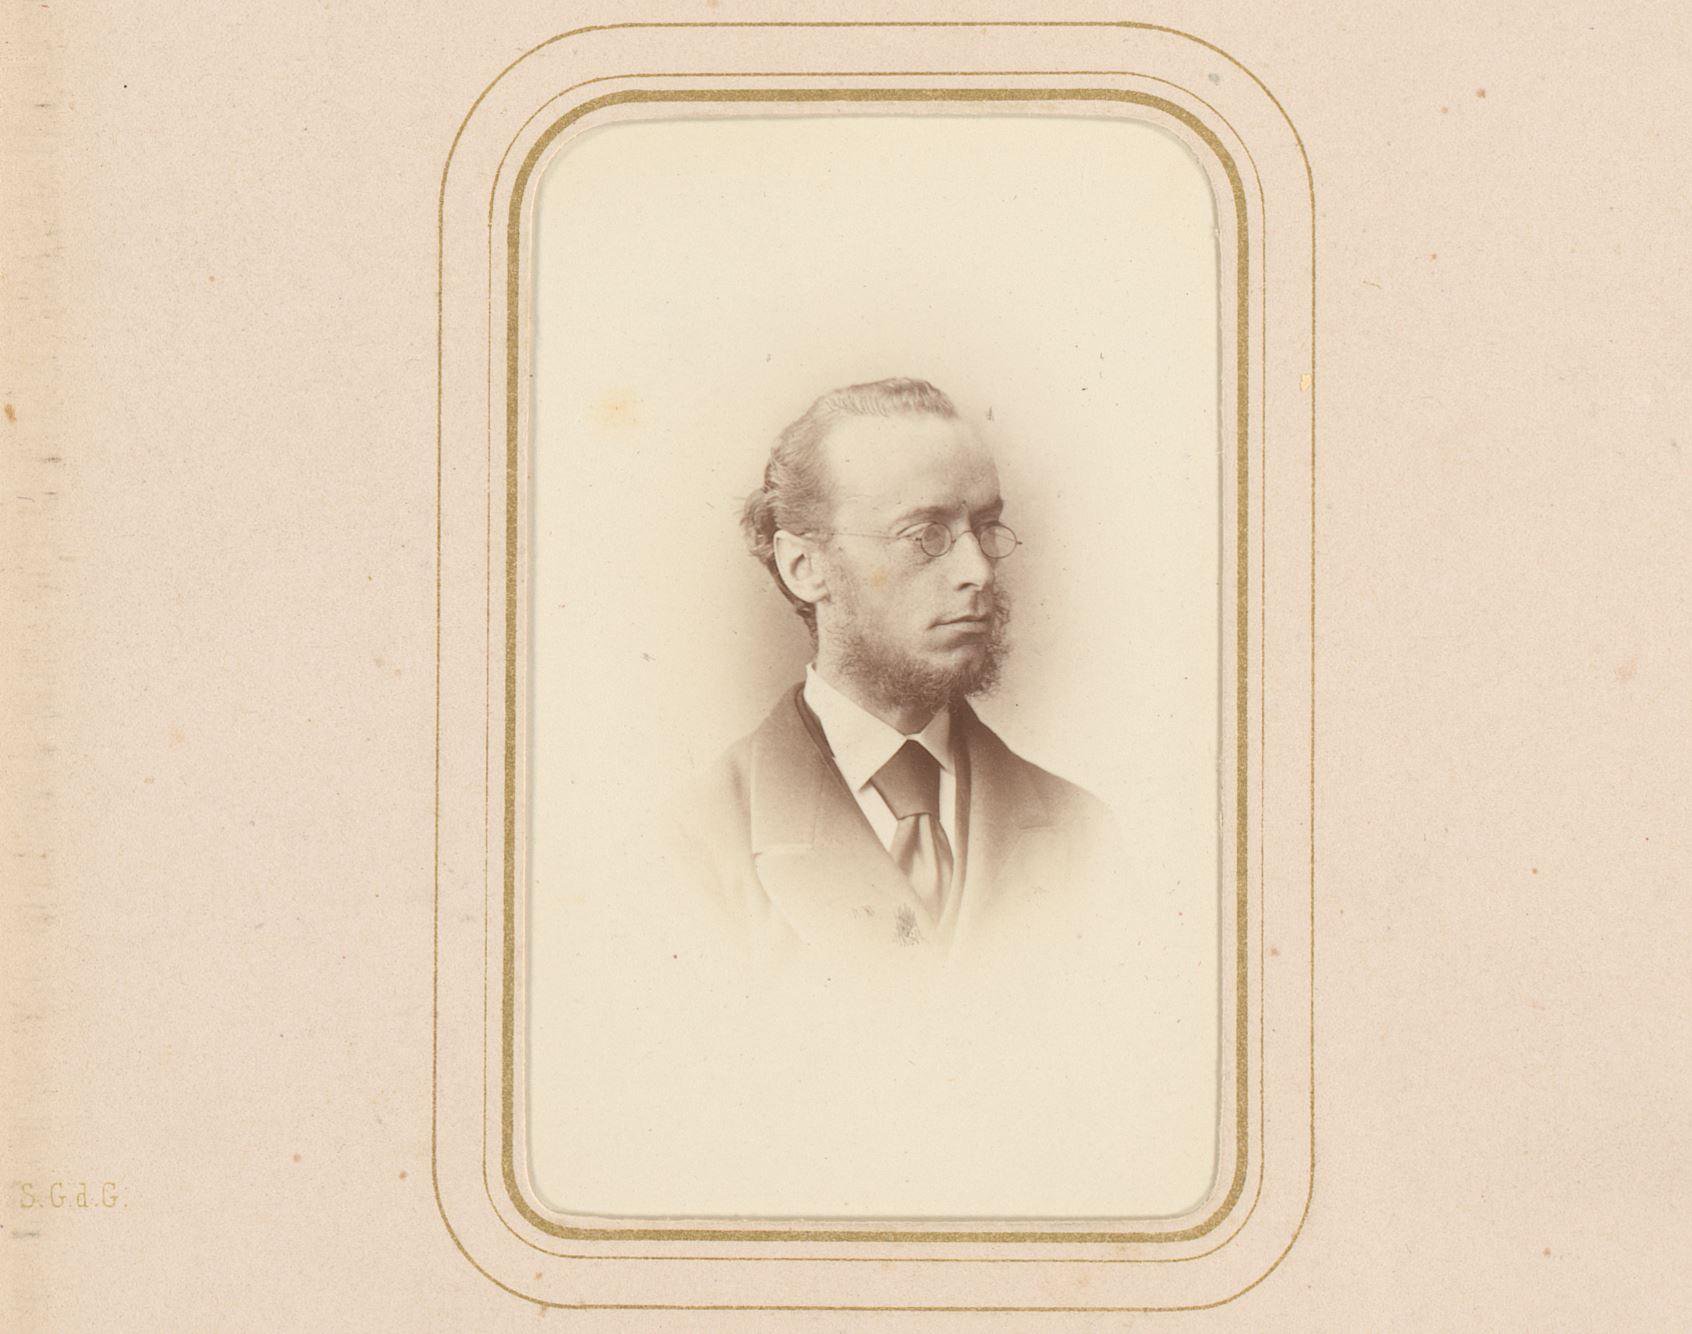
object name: album leaf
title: Portret van een man met baard en bril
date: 1863-1875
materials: cardboard, photographic support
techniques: albumen print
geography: london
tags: eyeglasses, spectacles, historical persons, beard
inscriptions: inscription: ‘G [+] R Lavis/ PHOTOGRAPHERS &/ MINIATURE PAINTERS/ 135, REGENT St/ W./ AND AT/ 42, Terminus Place,/ EASTBOURNE./ No.’